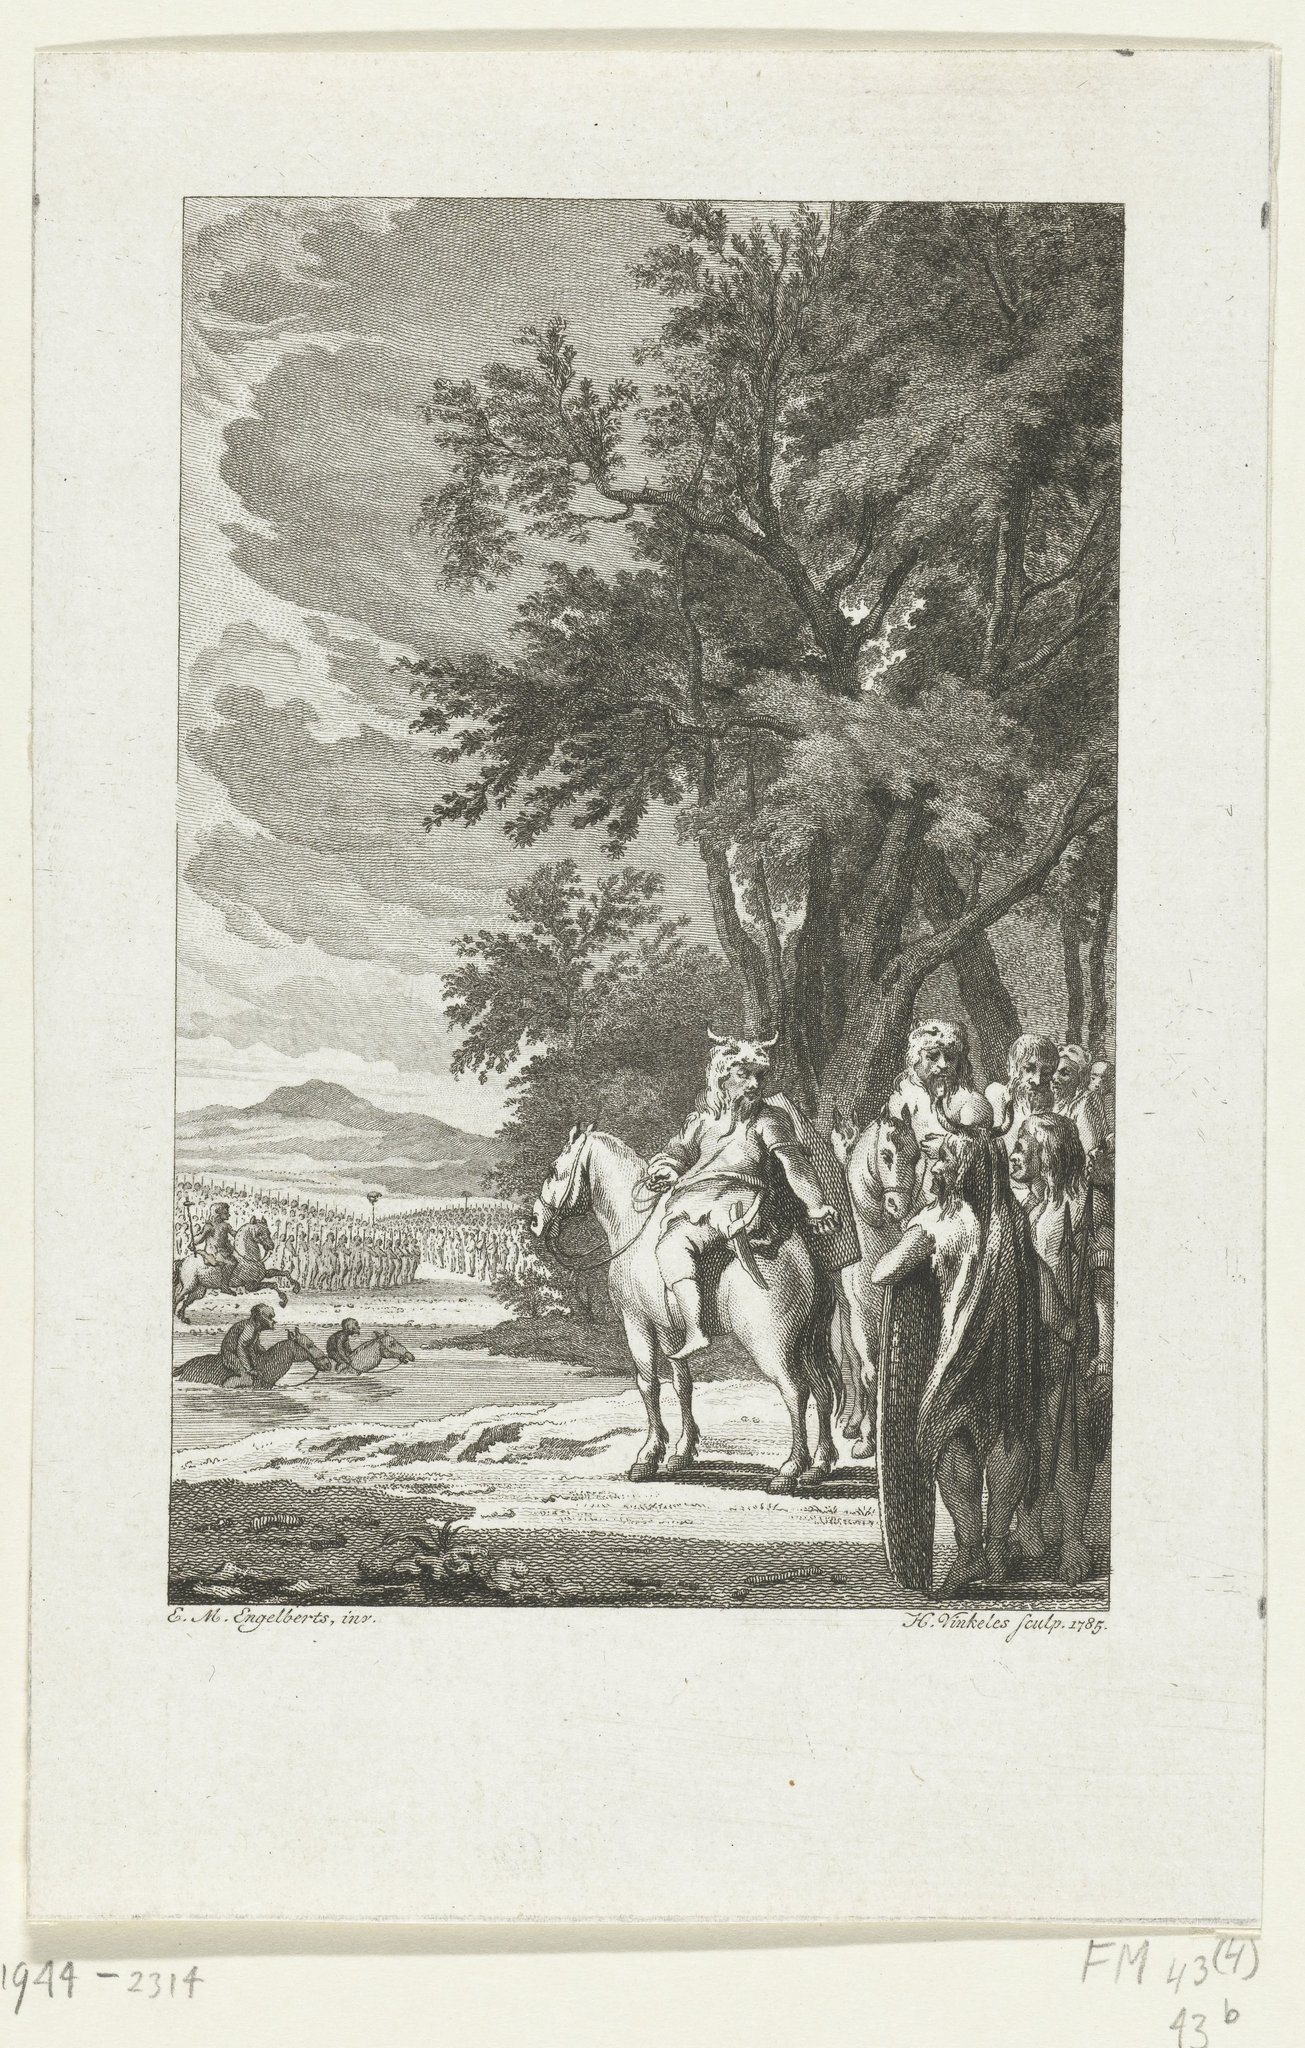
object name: print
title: Krijgsoefeningen bij de Bataven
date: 1785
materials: paper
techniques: etching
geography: netherlands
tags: military training, extinct, 'historical' peoples (with name), netherlands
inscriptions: date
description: Illustratie voor: E.M. Engelberts, De aloude staat en geschiedenissen der Vereenigde Nederlanden, Johannes Allart, Amsterdam 1784-1799. Staat vóór de letter.